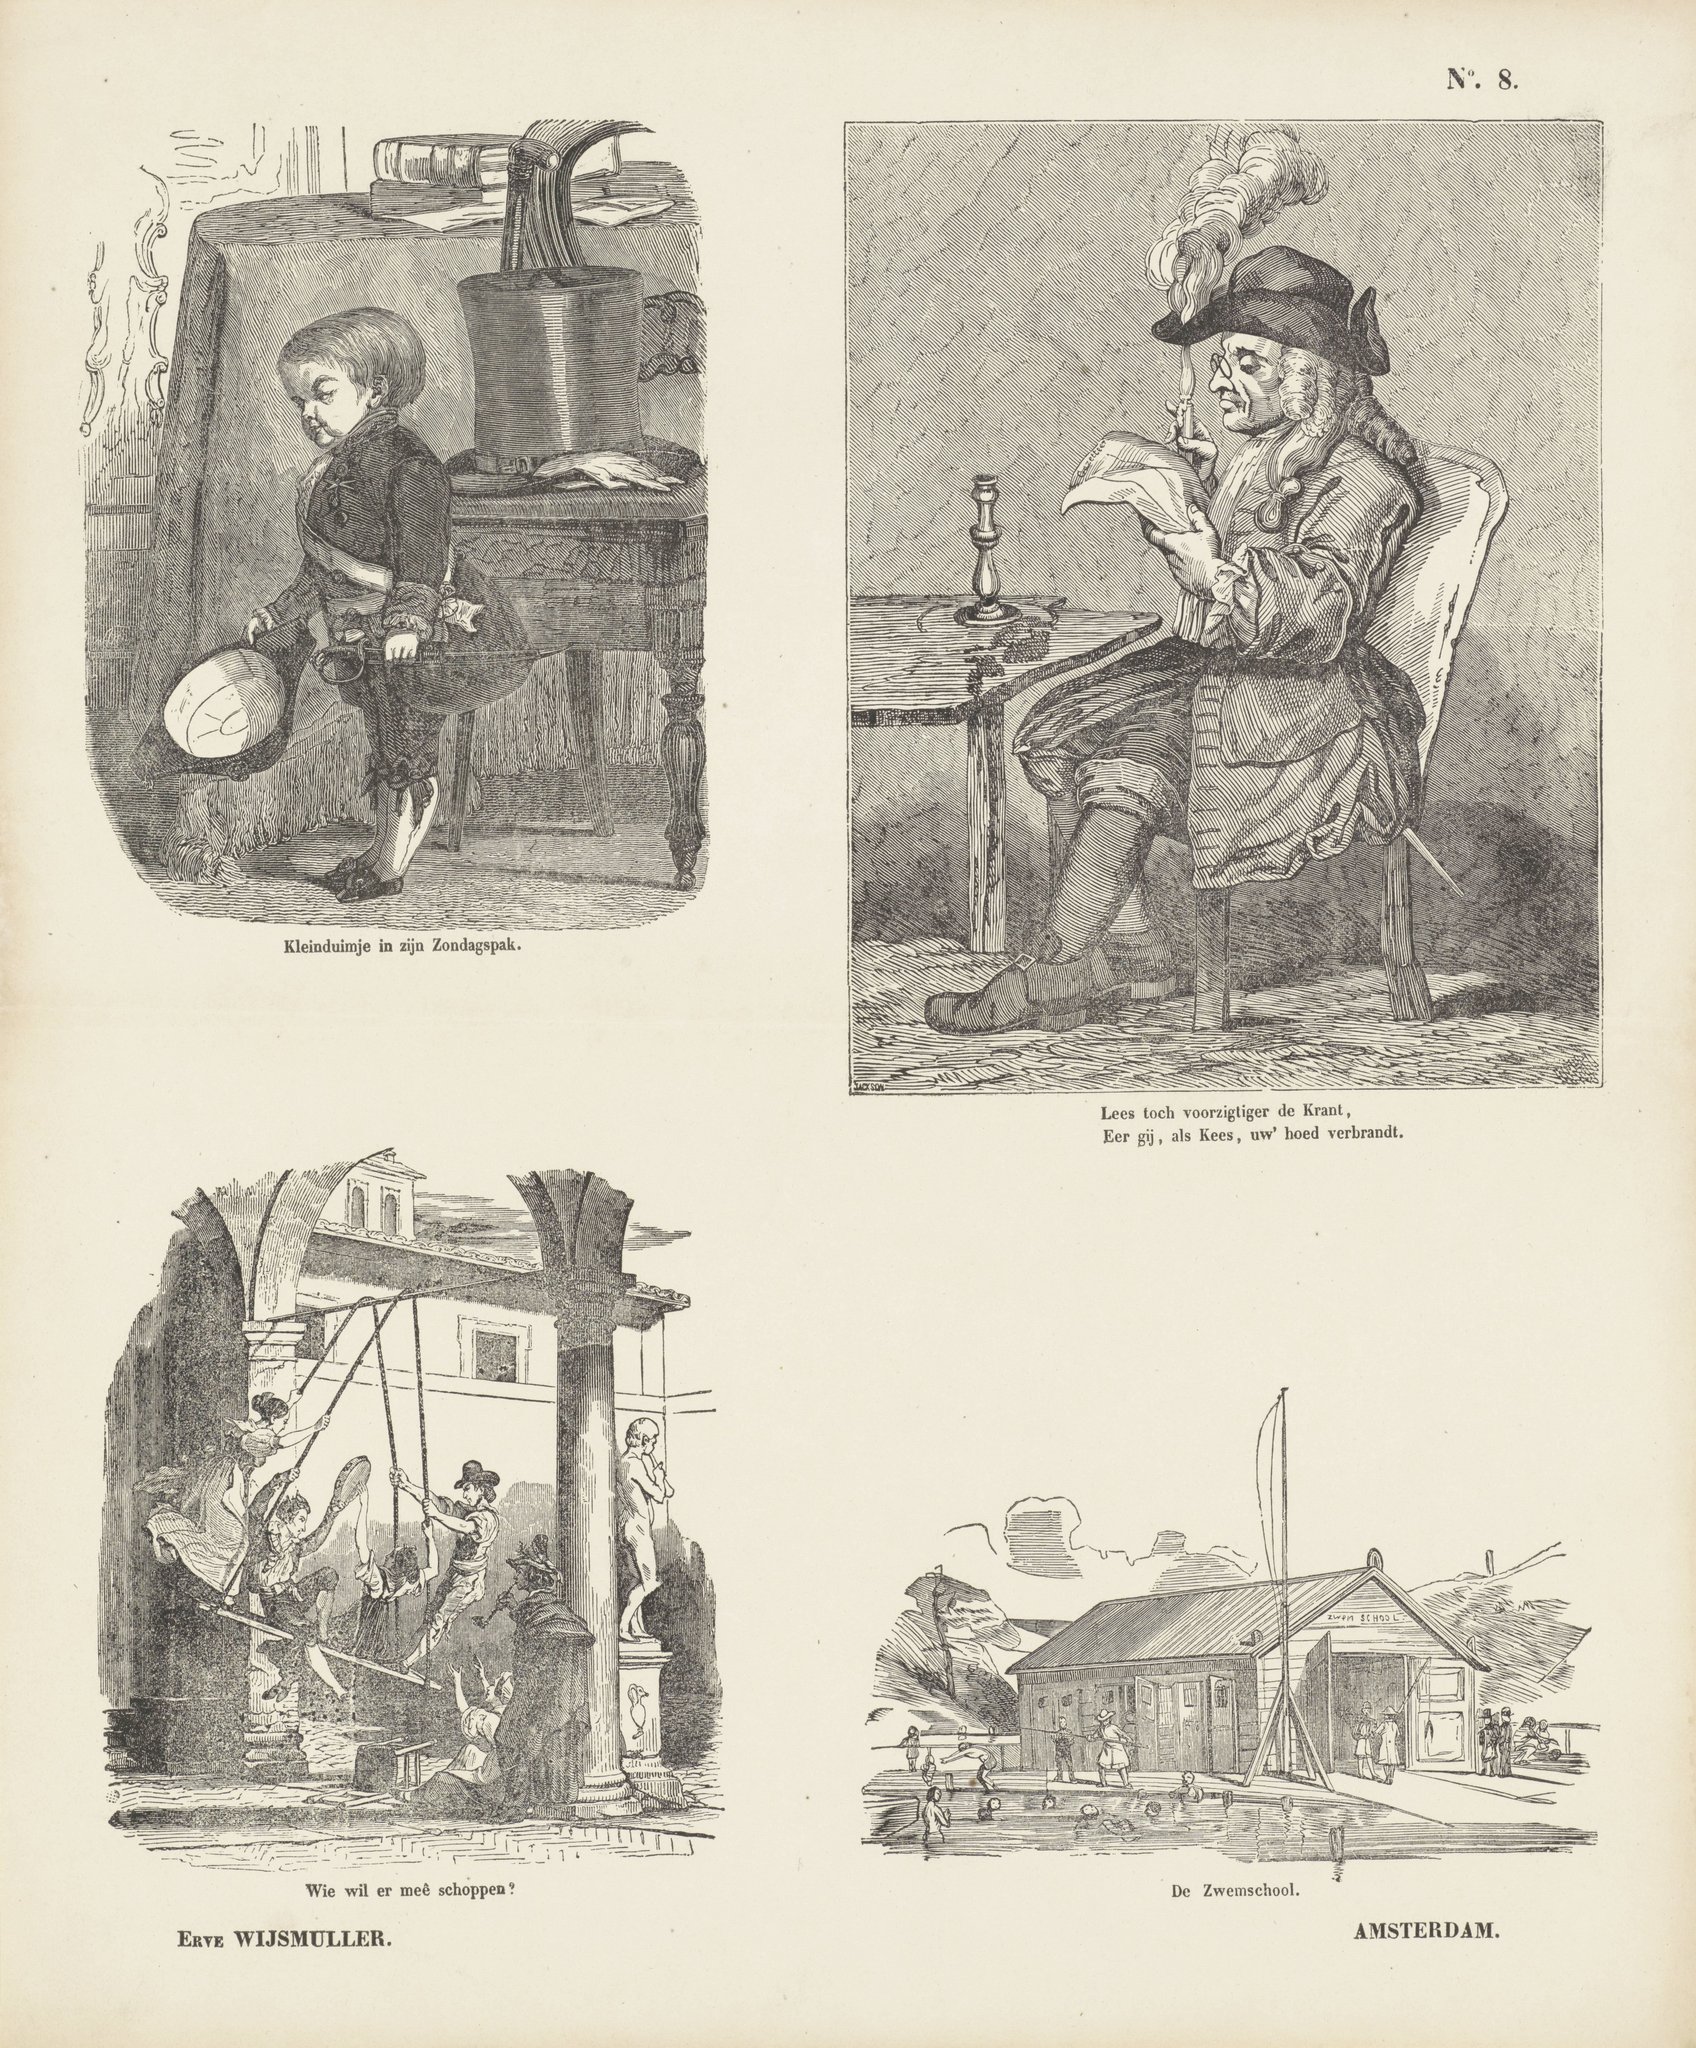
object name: popular print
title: Verschillende voorstellingen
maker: Anonymous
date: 1828-1913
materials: paper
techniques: letterpress printing, line block, engraving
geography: netherlands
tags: swimming (sport), swinging (children's game), tales and fairy tales: little thumbling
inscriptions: collector's mark: Lugt 2760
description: Blad met 4 voorstellingen van verschillende aard, waaronder Klein Duimpje, een lezende man die zijn hoed in brand steekt, een schommel en een zwemschool. Onder elke afbeelding een onderschrift. Onder de eerste afbeelding het onderschrift: Kleinduimpje in zijn zondagspak. Genummerd rechtsboven: No. 8.